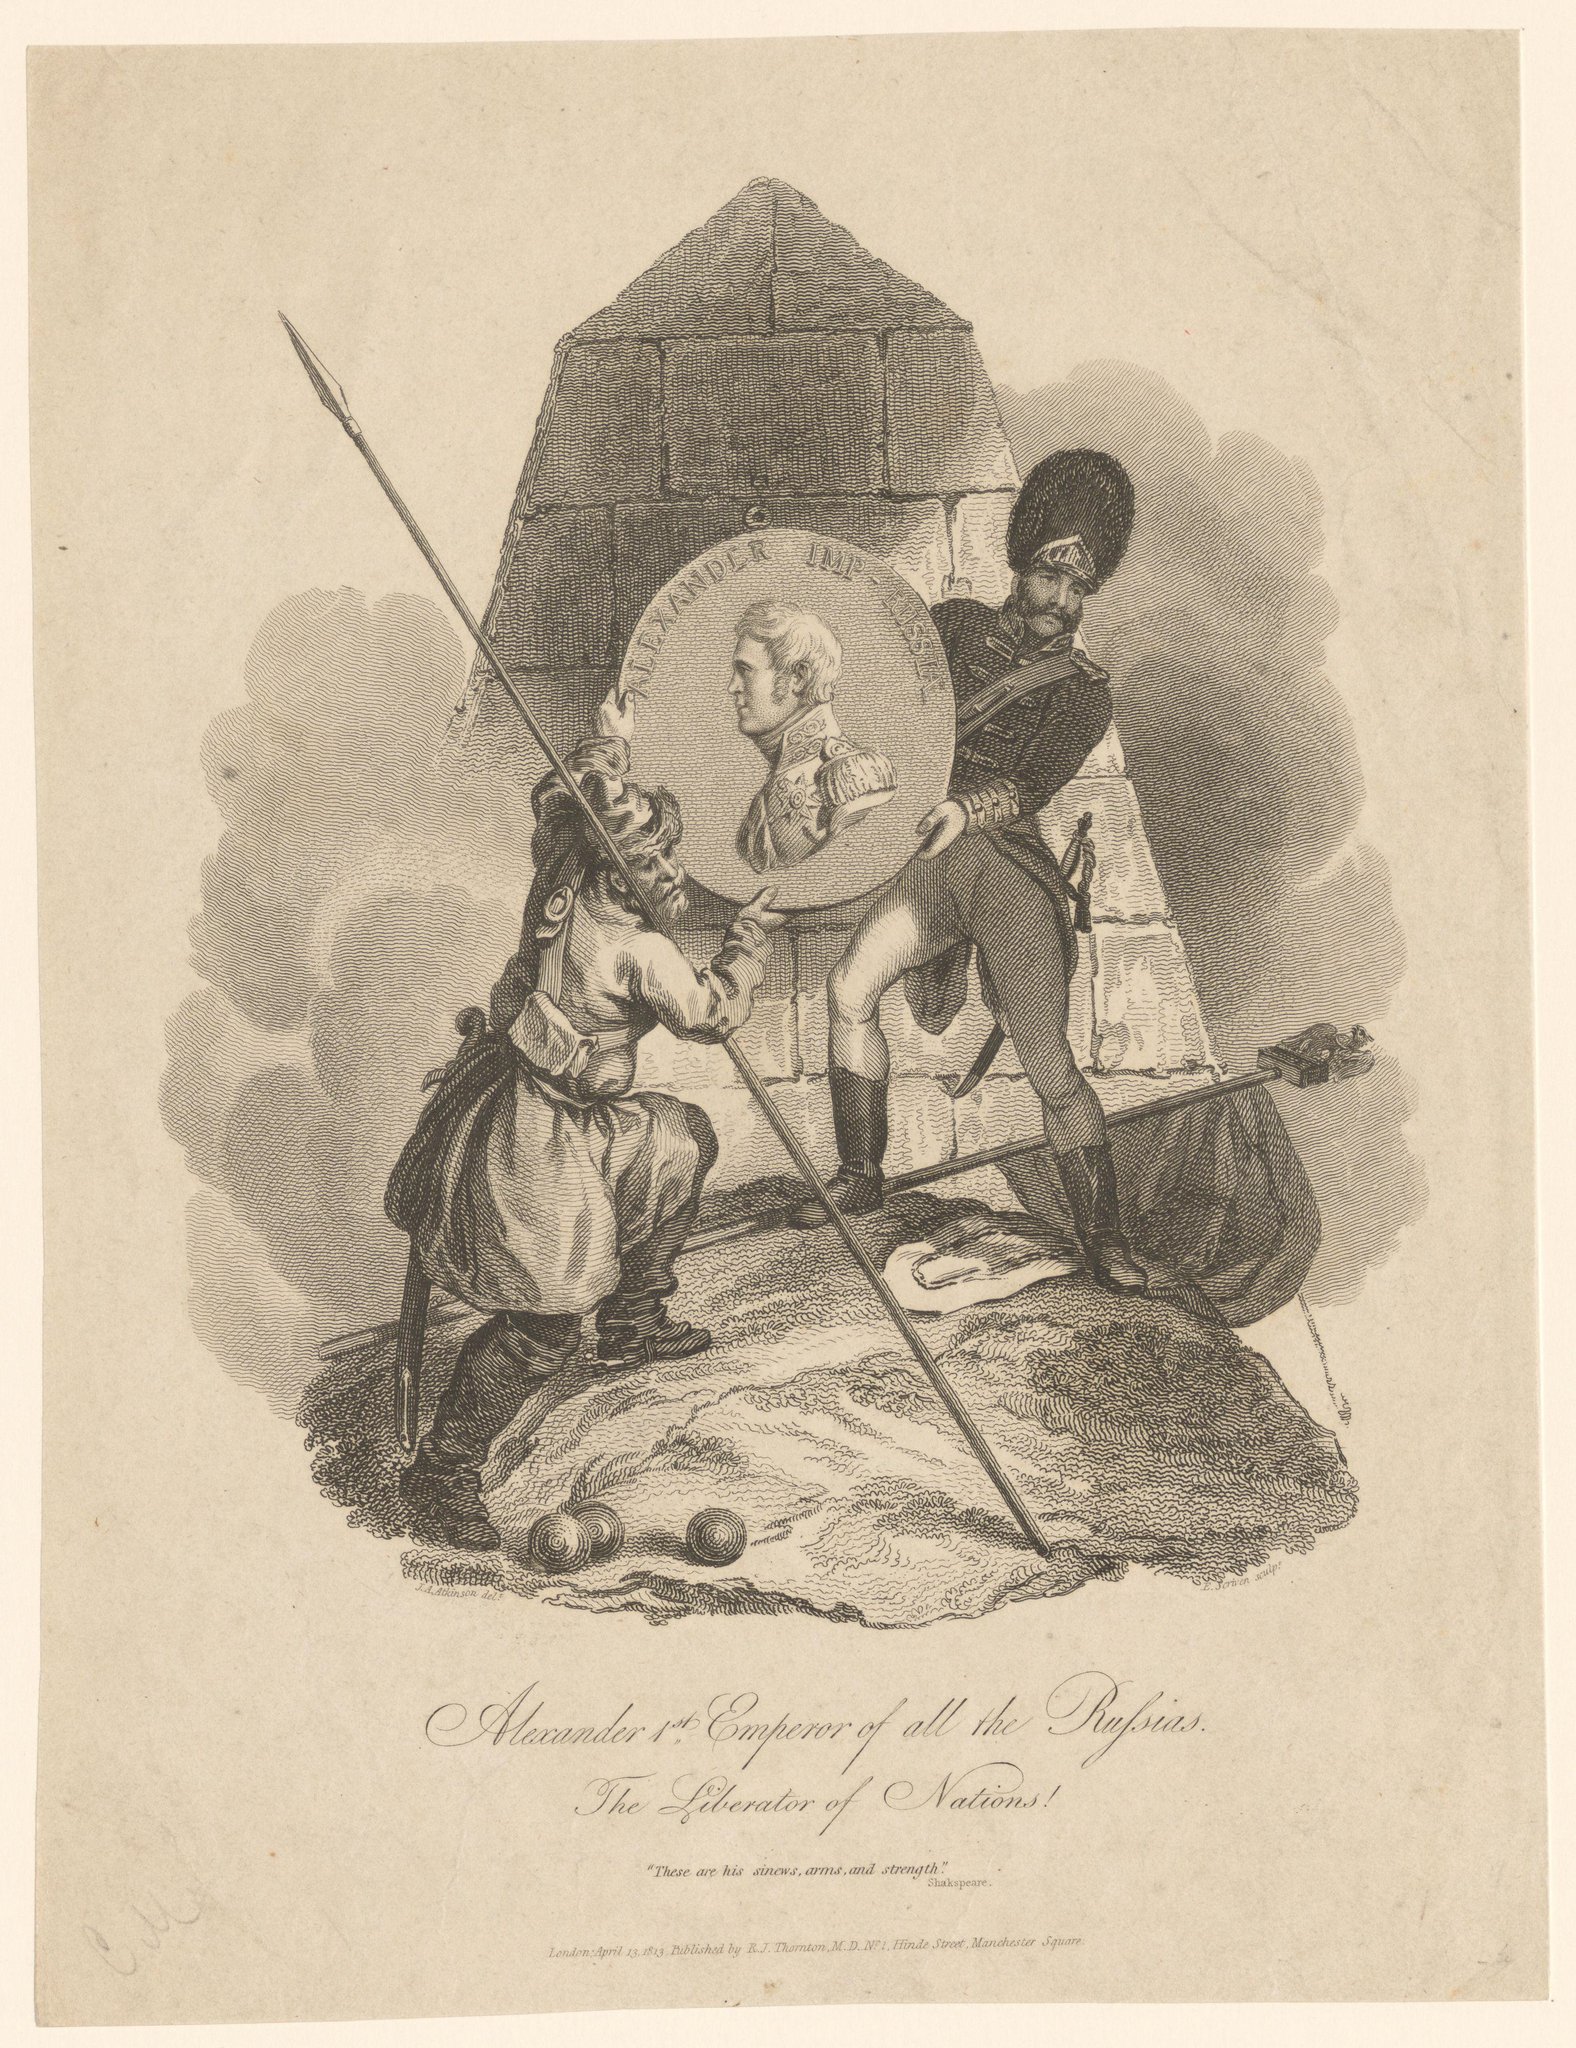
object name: print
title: Twee officieren houden een gedenkteken voor Alexander I van Rusland op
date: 1813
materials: paper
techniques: engraving, etching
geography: london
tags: alexander i (tsaar van rusland), reunion, memorial gathering (~ veteran soldiers), historical persons, memorial medal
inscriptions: collector's mark: Lugt 2228